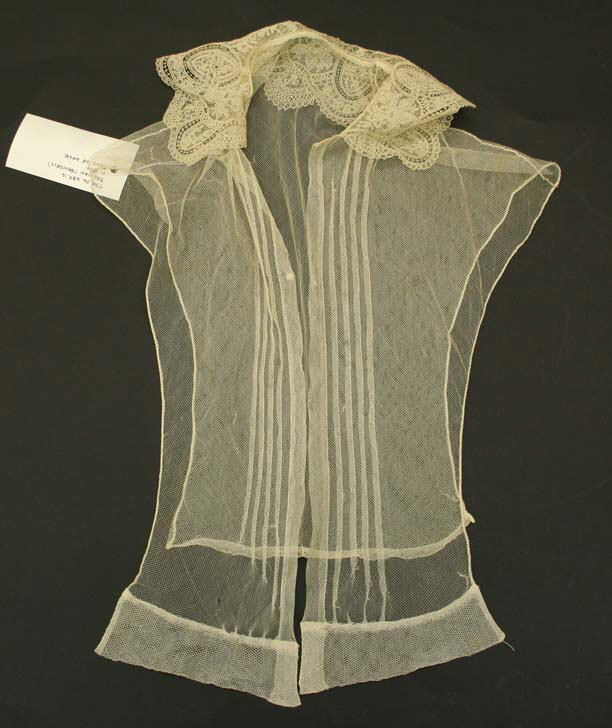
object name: collar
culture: belgian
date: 1850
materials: linen, silk